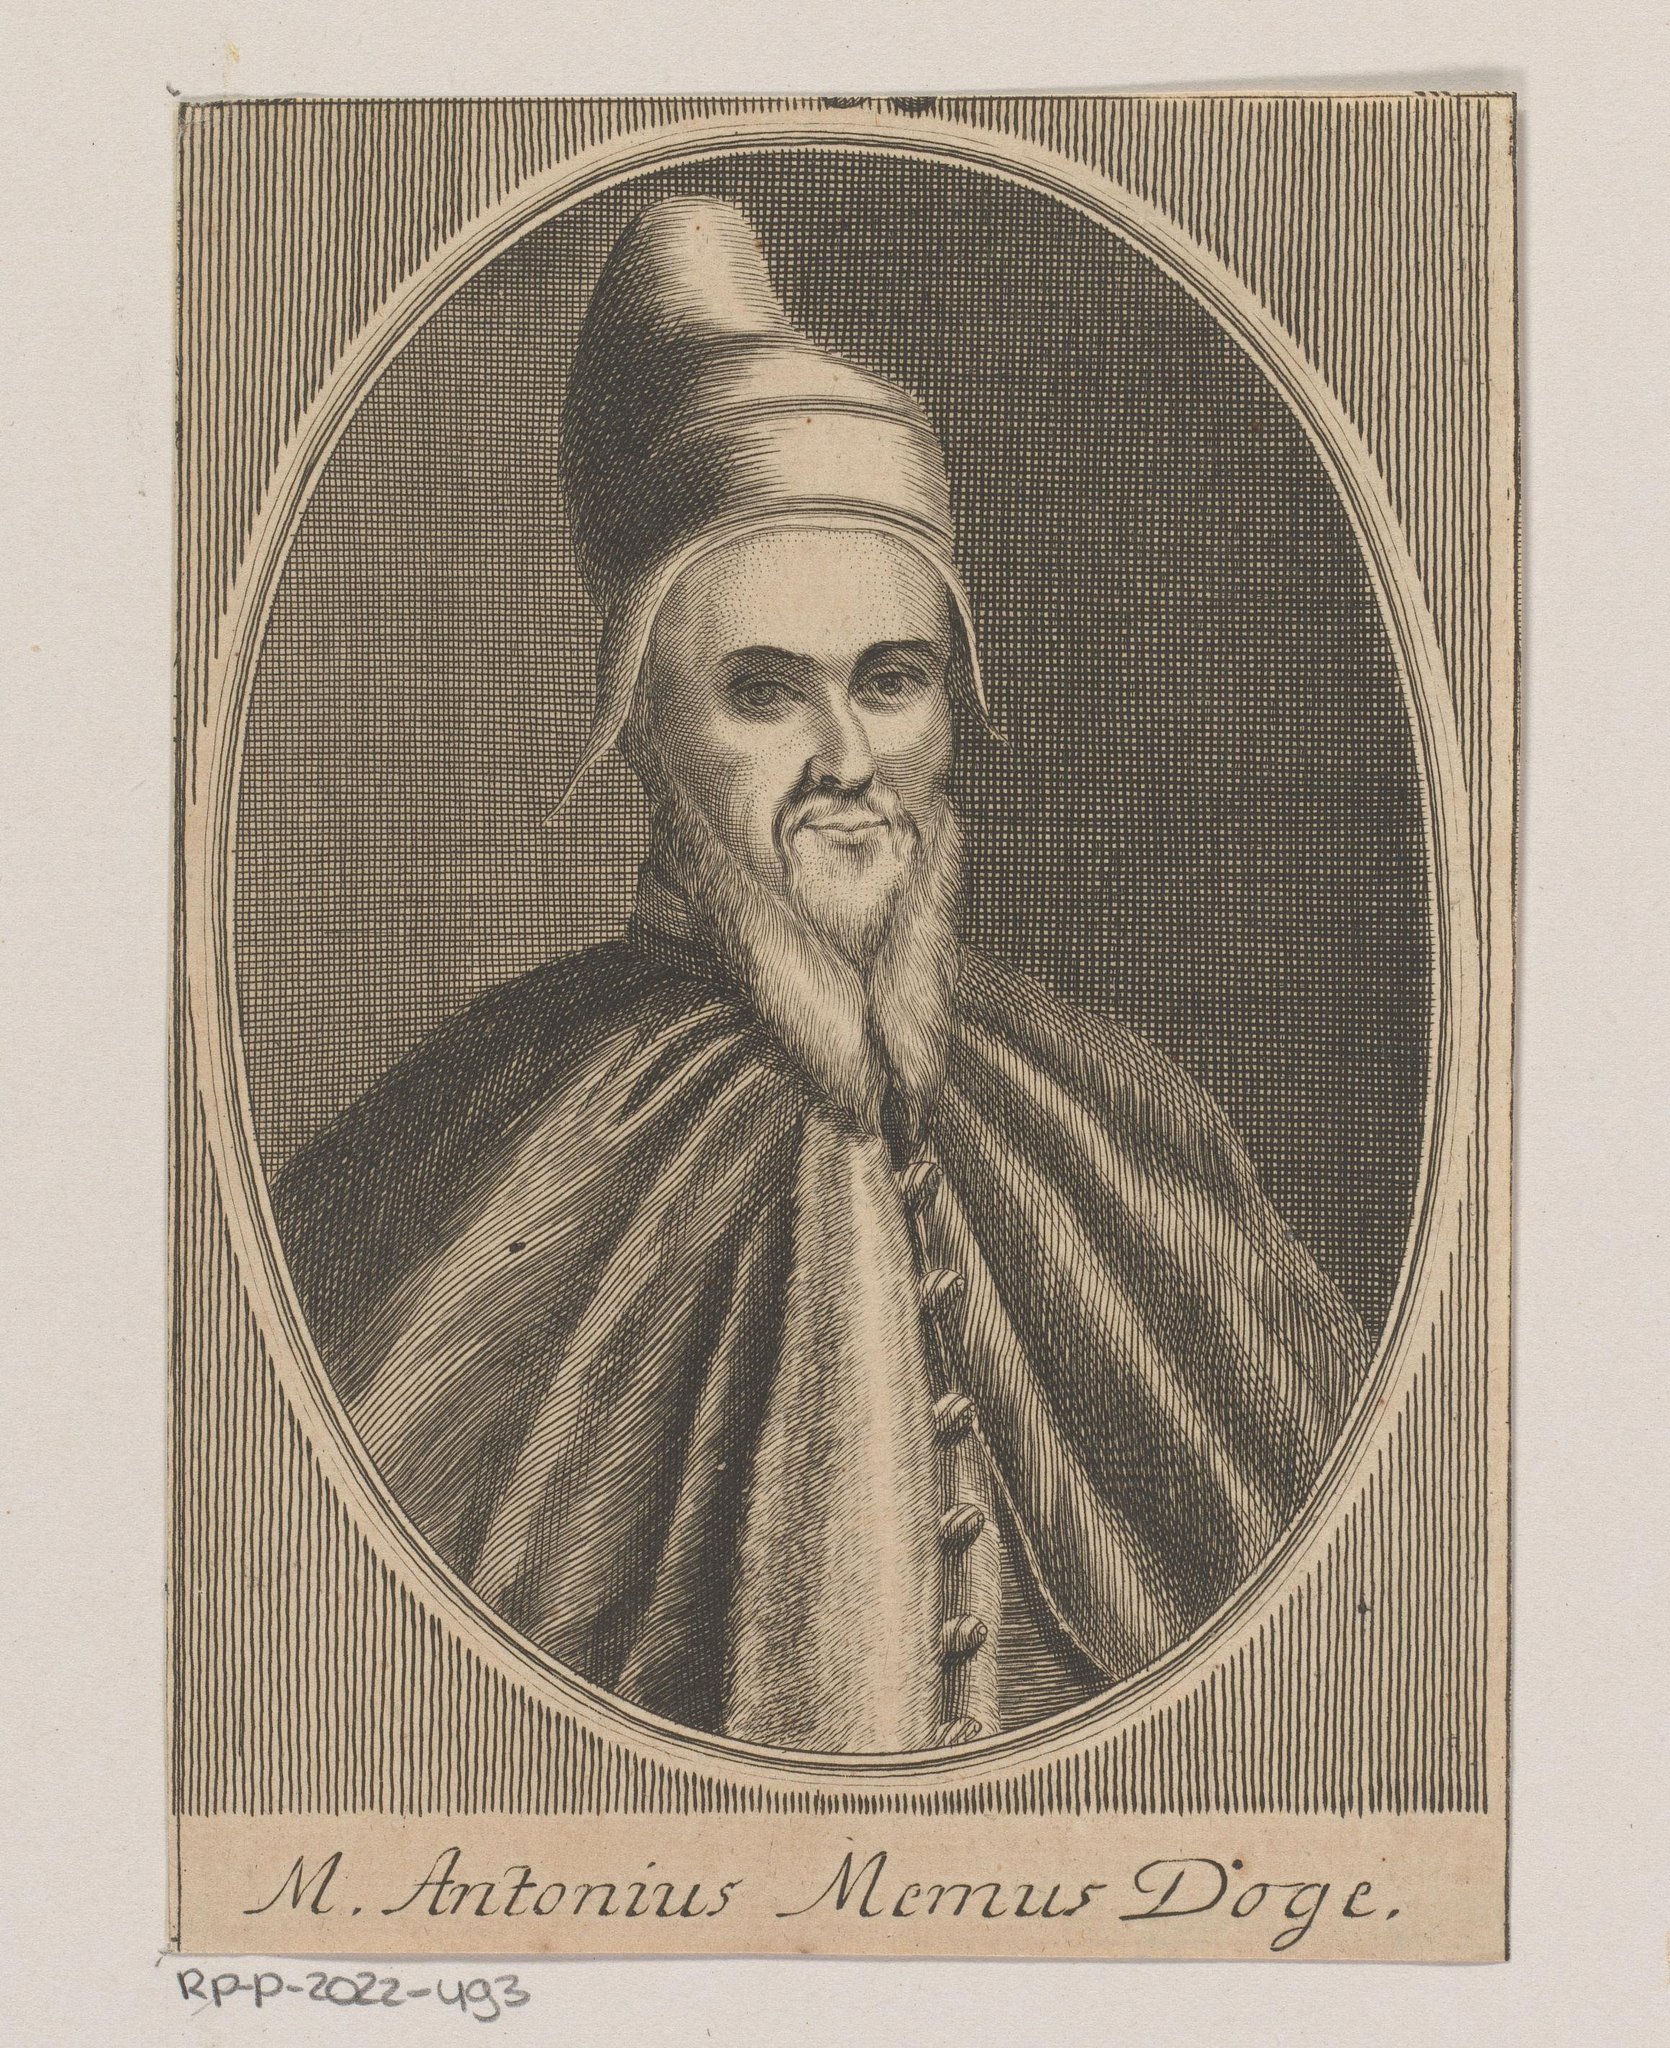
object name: print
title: Portret van Marcantonio Memmo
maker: Anonymous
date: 1600-1750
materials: paper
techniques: engraving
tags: venice, historical persons